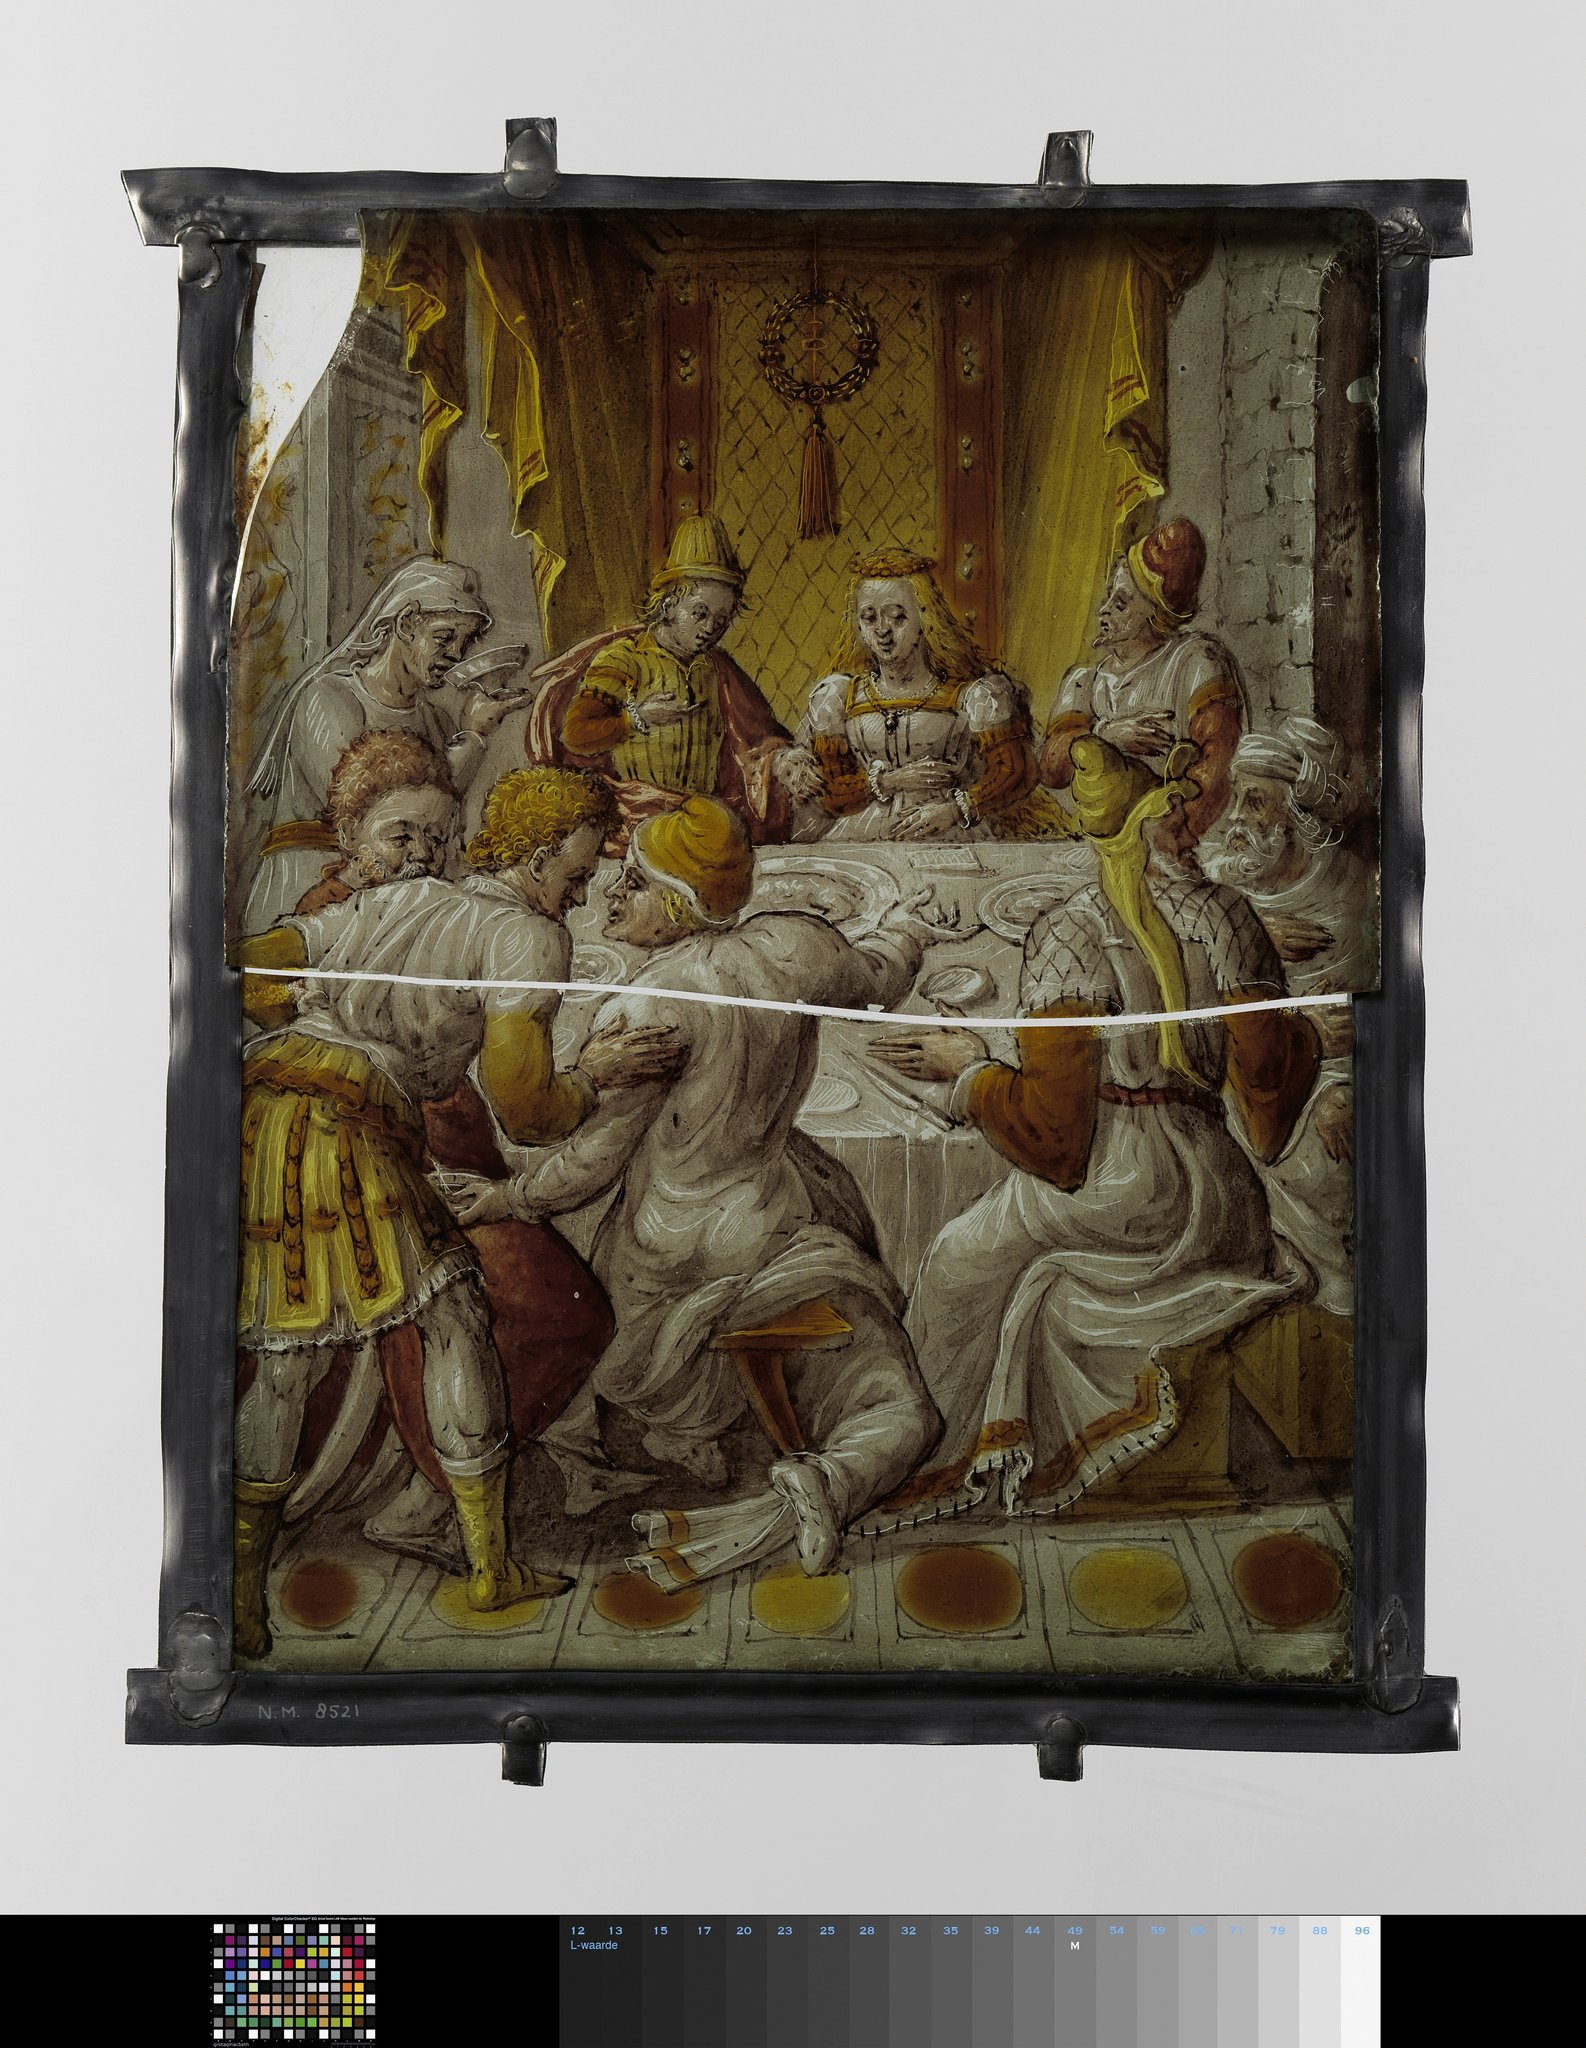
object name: light window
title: Ruit met het bruiloftsmaal van Esther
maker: Anonymous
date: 1550-1600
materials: glass, lead, pigment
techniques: leading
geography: northern netherlands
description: Gebrandschilderde rechthoekige ruitje in grijs, geel en bruin voorstellende het bruiloftsmaal van Esther. In een vertrek staan en zitten negen personen rondom een tafel. Voor het venster achter het bruidspaar hangt een krans.